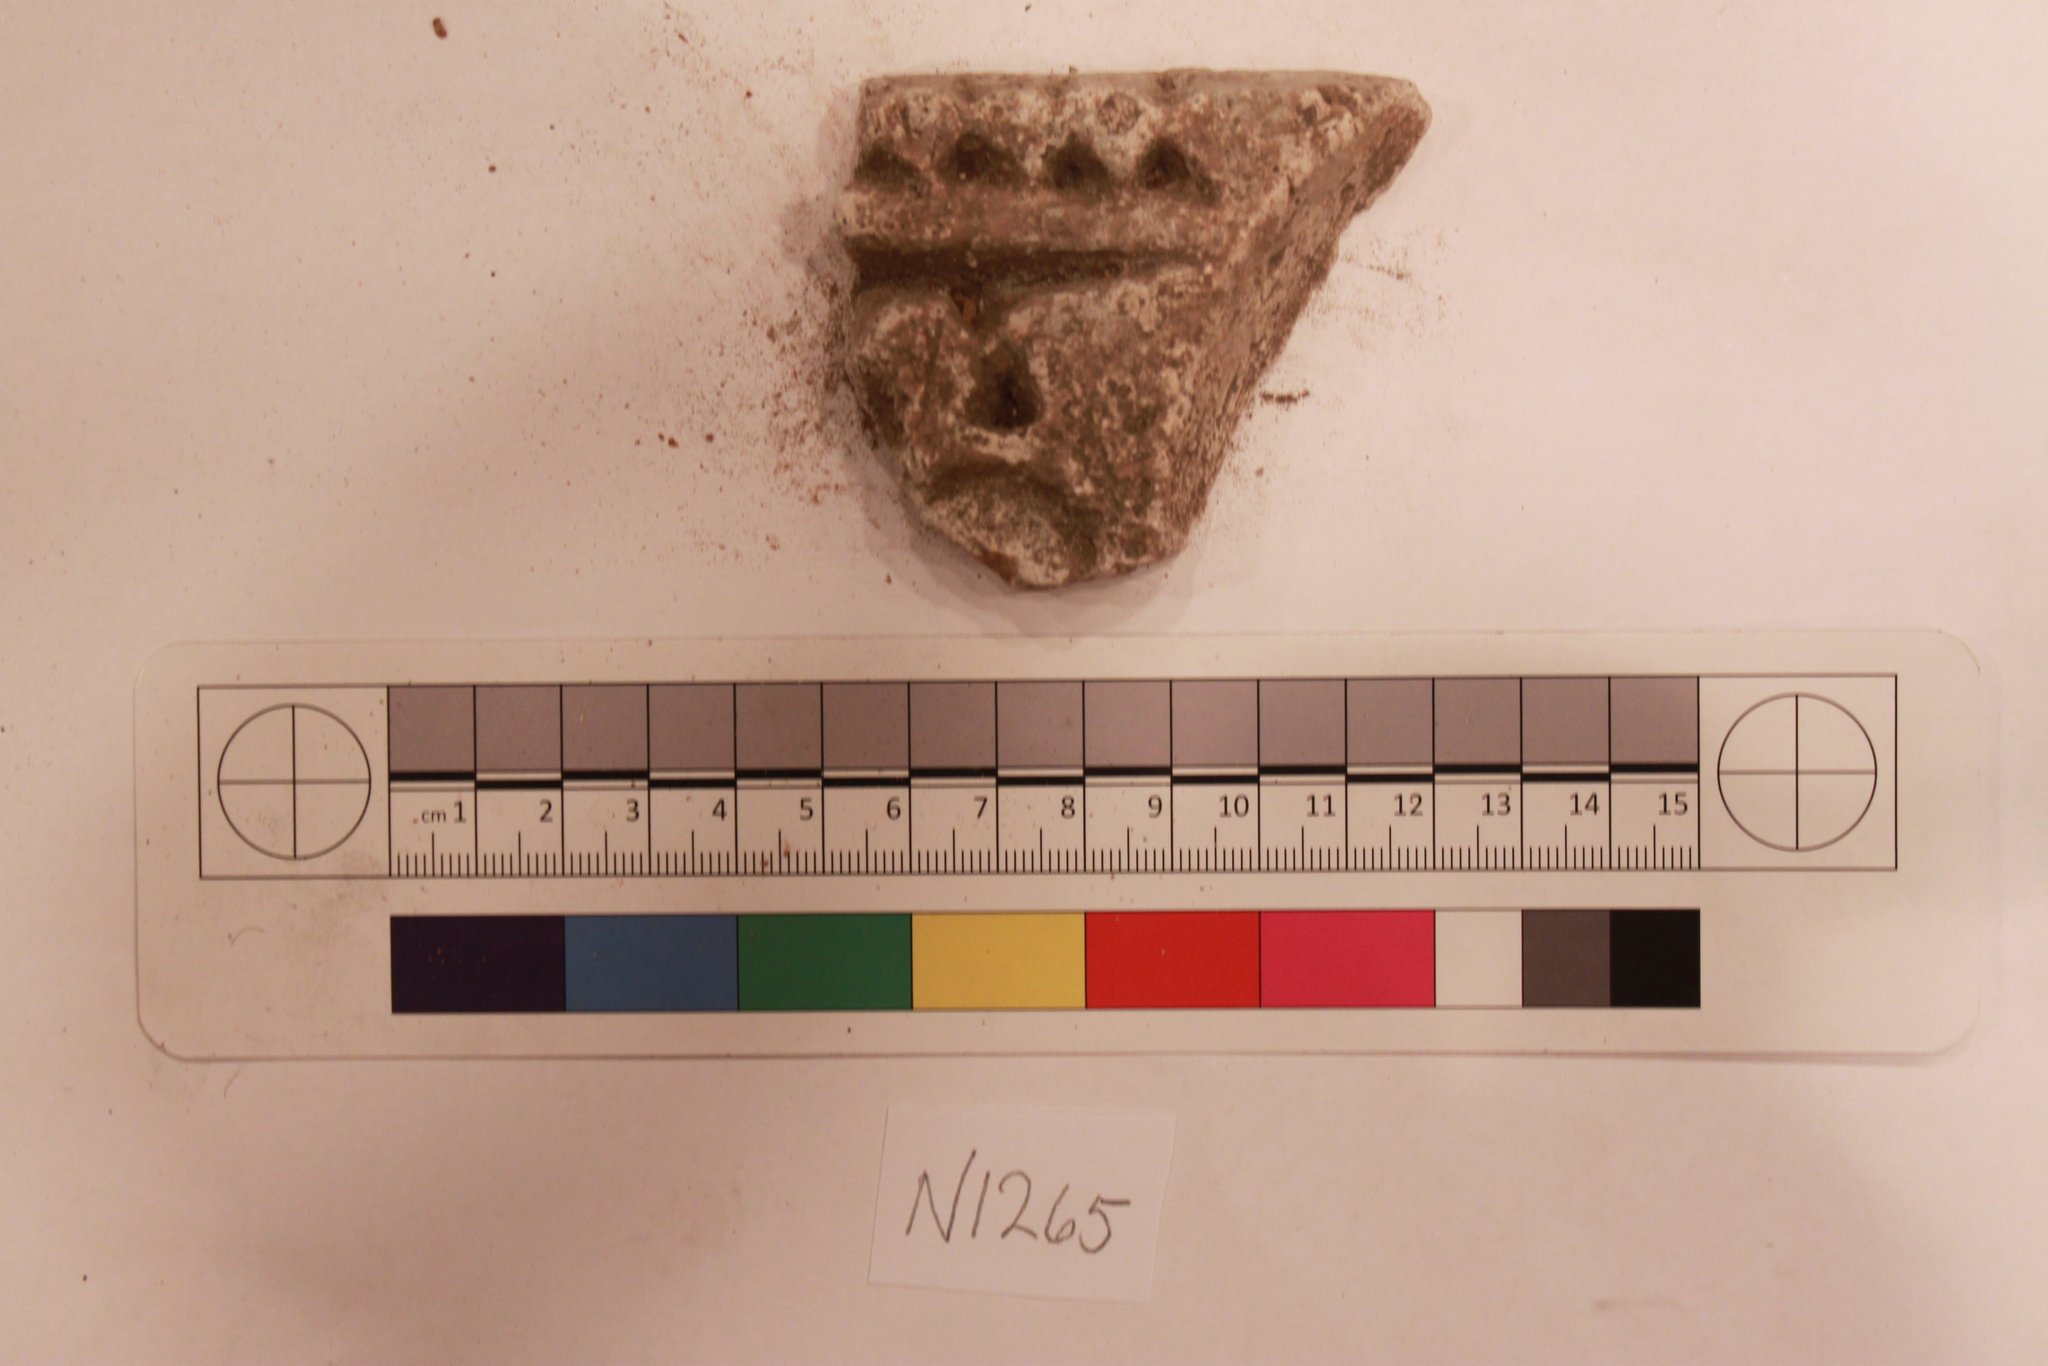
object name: fragment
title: Stucco Fragment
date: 701-1200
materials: plaster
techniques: carving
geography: iran